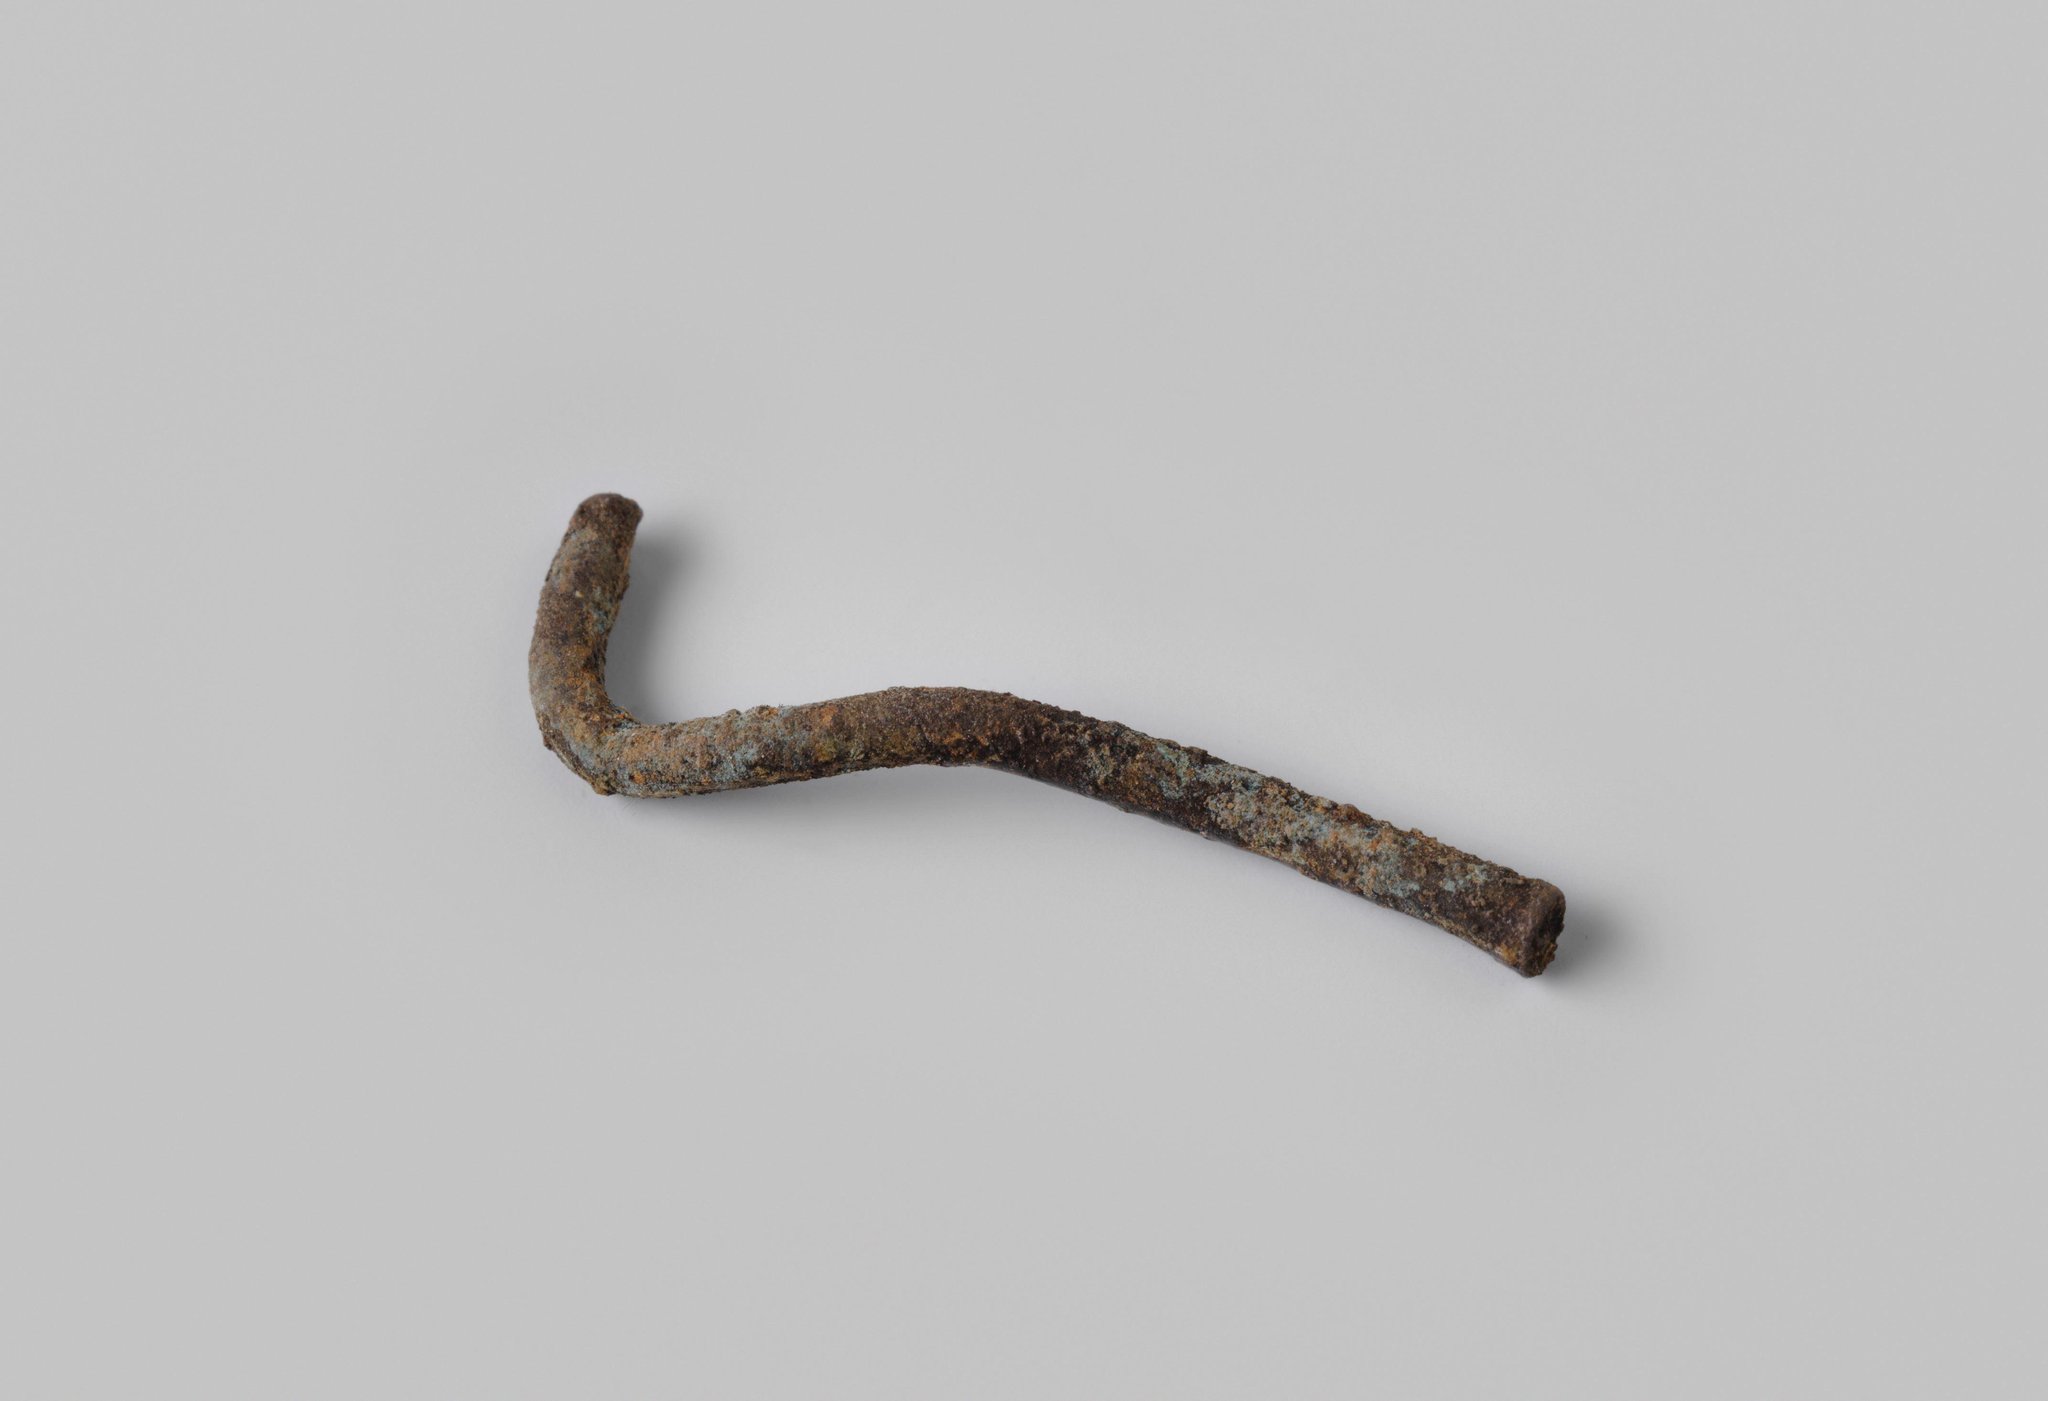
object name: wire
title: Koperdraad uit het wrak van de Oost-Indiëvaarder Hollandia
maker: Anonymous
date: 1700-1743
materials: copper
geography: netherlands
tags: verenigde oostindische compagnie, hollandia (schip), annet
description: Varied parts or fragments, wire; fragm, bent, circular in section.